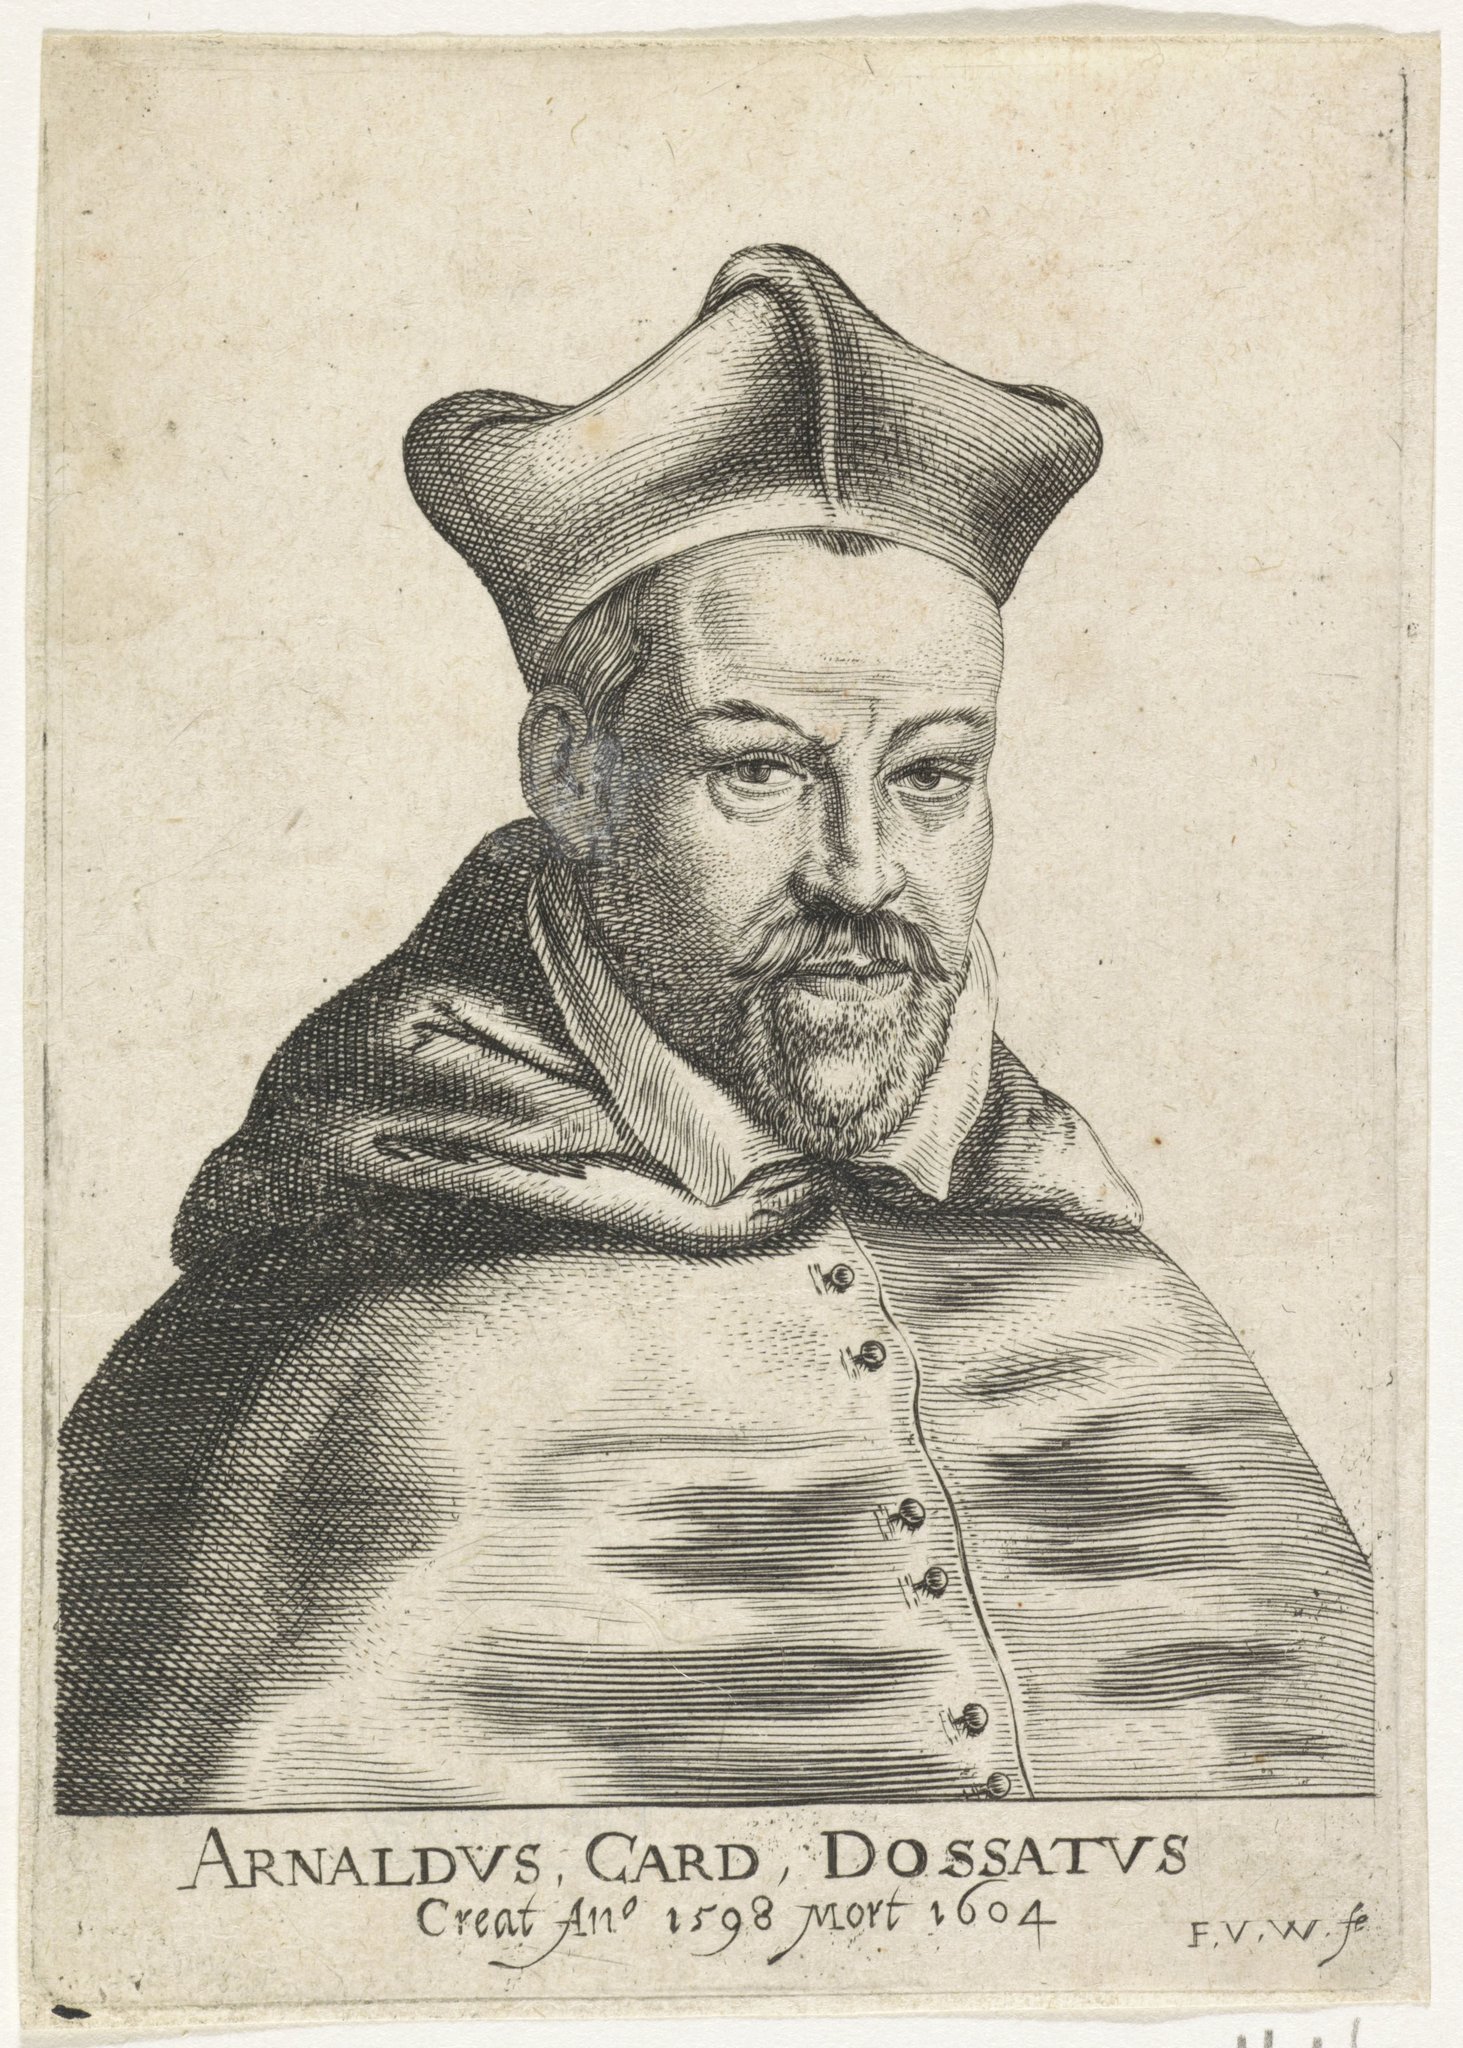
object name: print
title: Portret van de Franse kardinaal Arnaud d'Ossat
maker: frans van den wijngaerde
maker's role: print maker, publisher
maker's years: 1614-1679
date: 1644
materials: paper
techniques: engraving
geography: antwerp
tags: cardinal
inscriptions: collector's mark: Lugt 2228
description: Prent gebruikt in: Albi, Henri. Eloges historiques des Cardinaux illustres François et etrangers mis en parallele. Parijs: Anthoine de Cay, 1644.